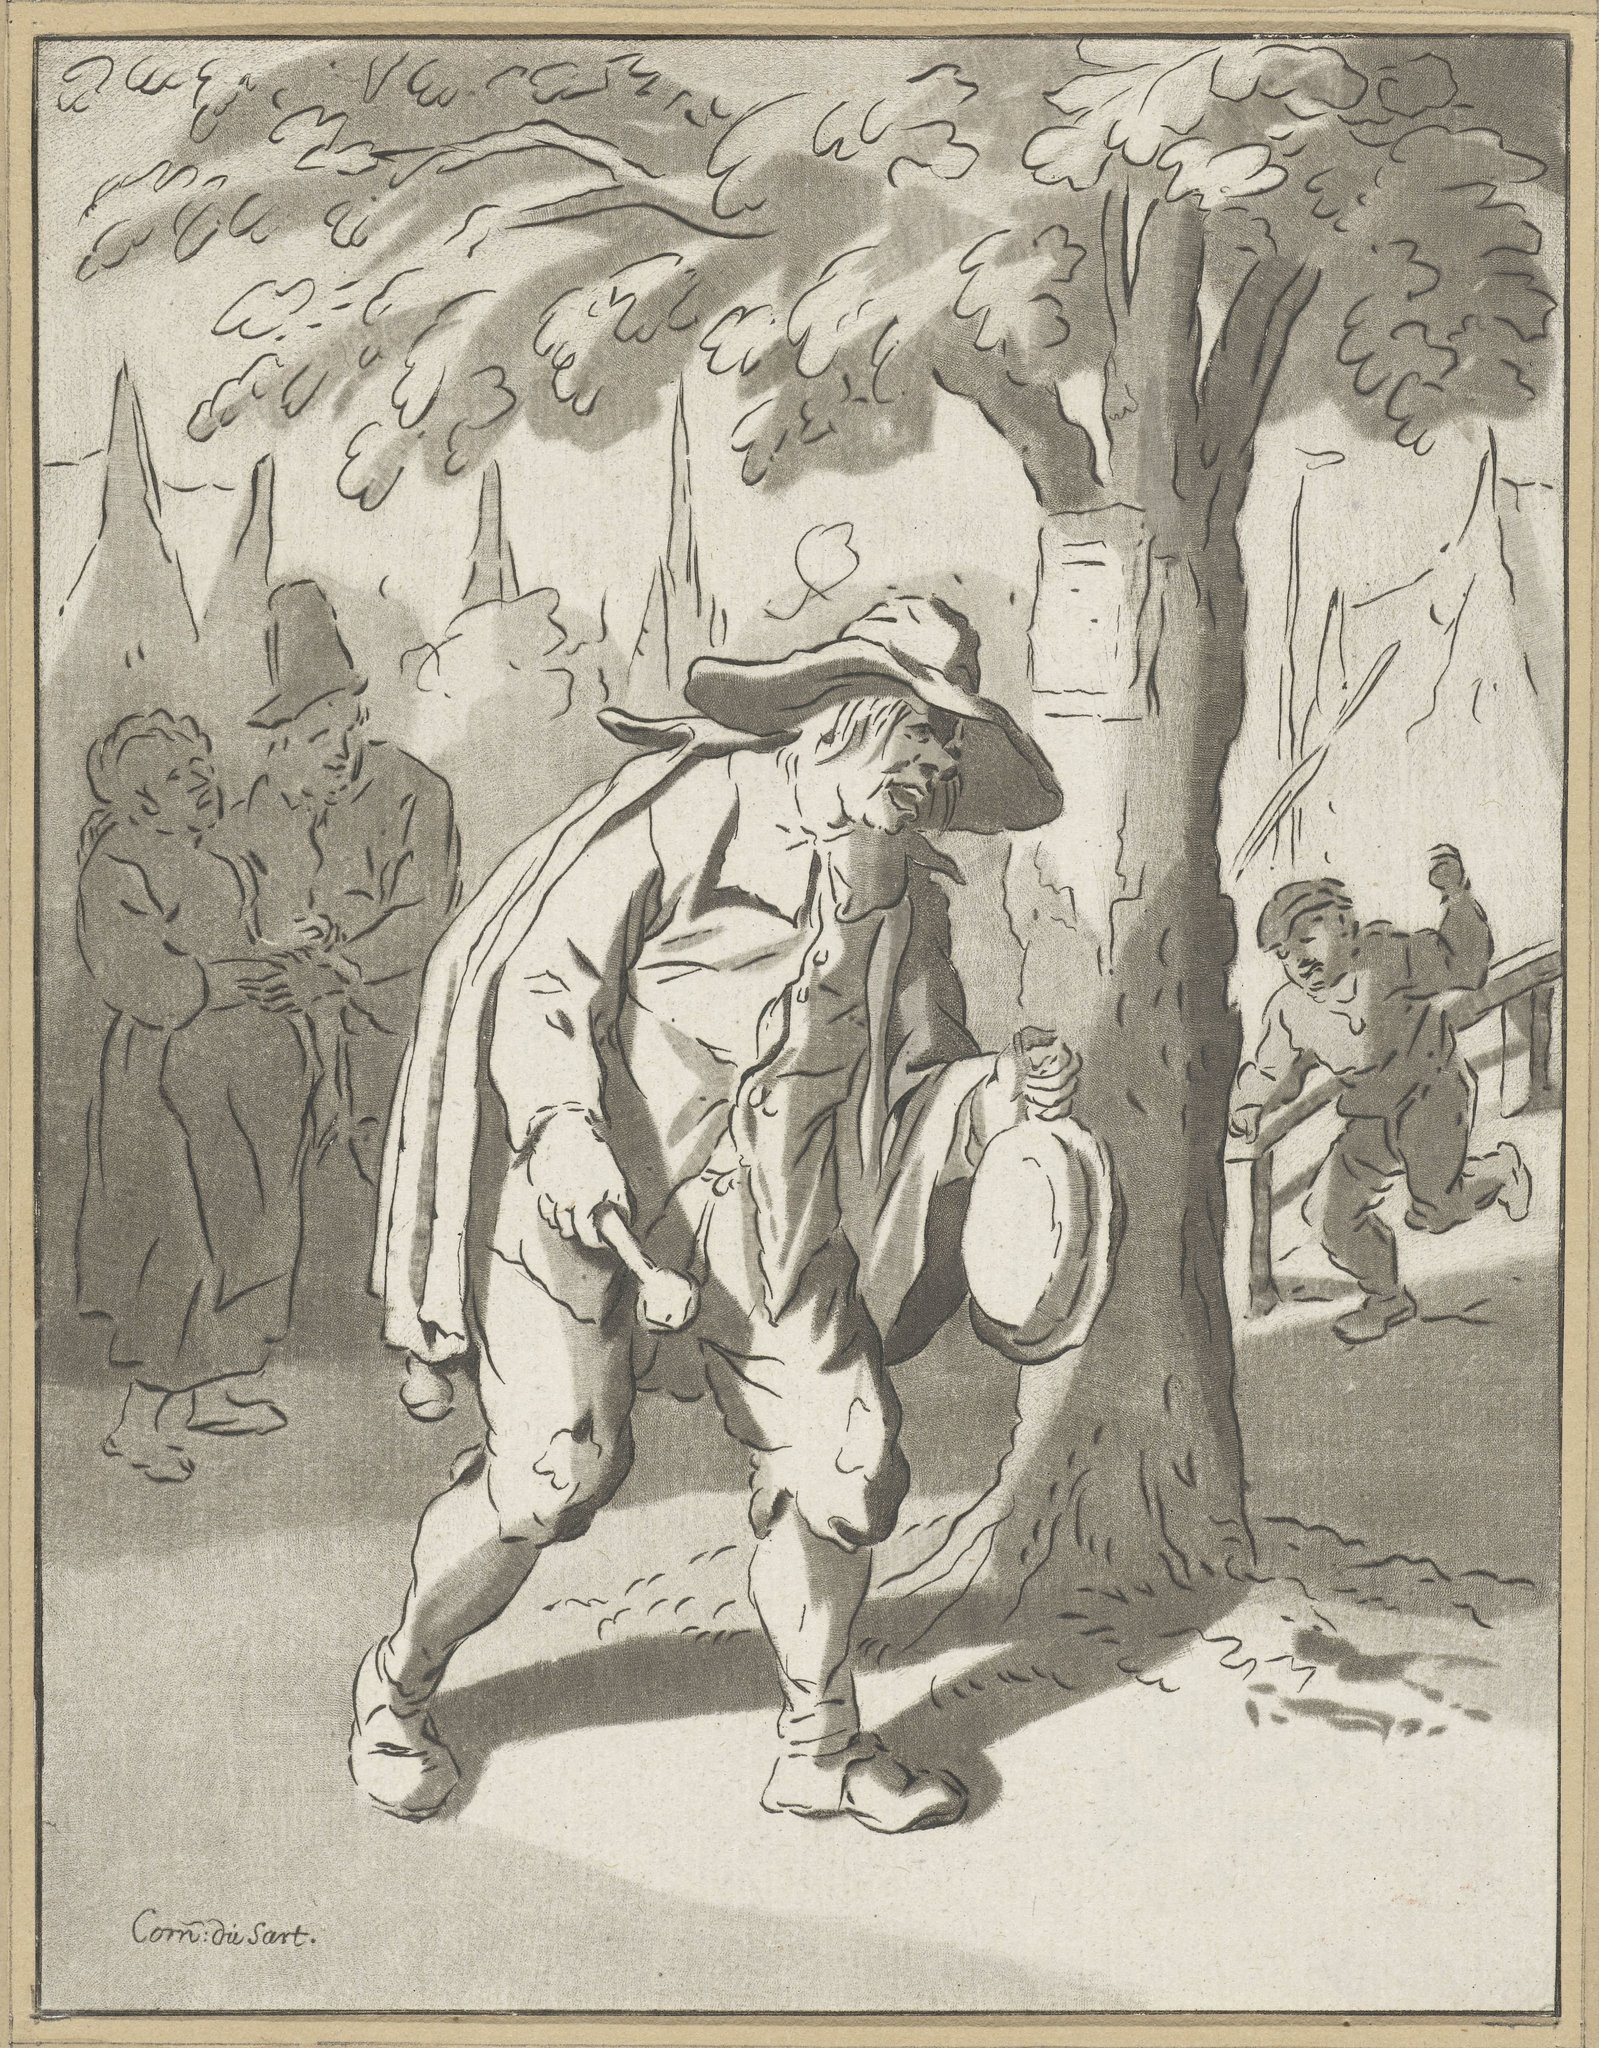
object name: print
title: Omroeper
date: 1776-1777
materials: paper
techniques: etching, roulette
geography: amsterdam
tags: oral spreading of news, town crier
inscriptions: collector's mark: Lugt 12, collector's mark: Lugt 2725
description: Een stadsomroeper met slagwerk bij een boom. Op de achtergrond luisterende mensen.